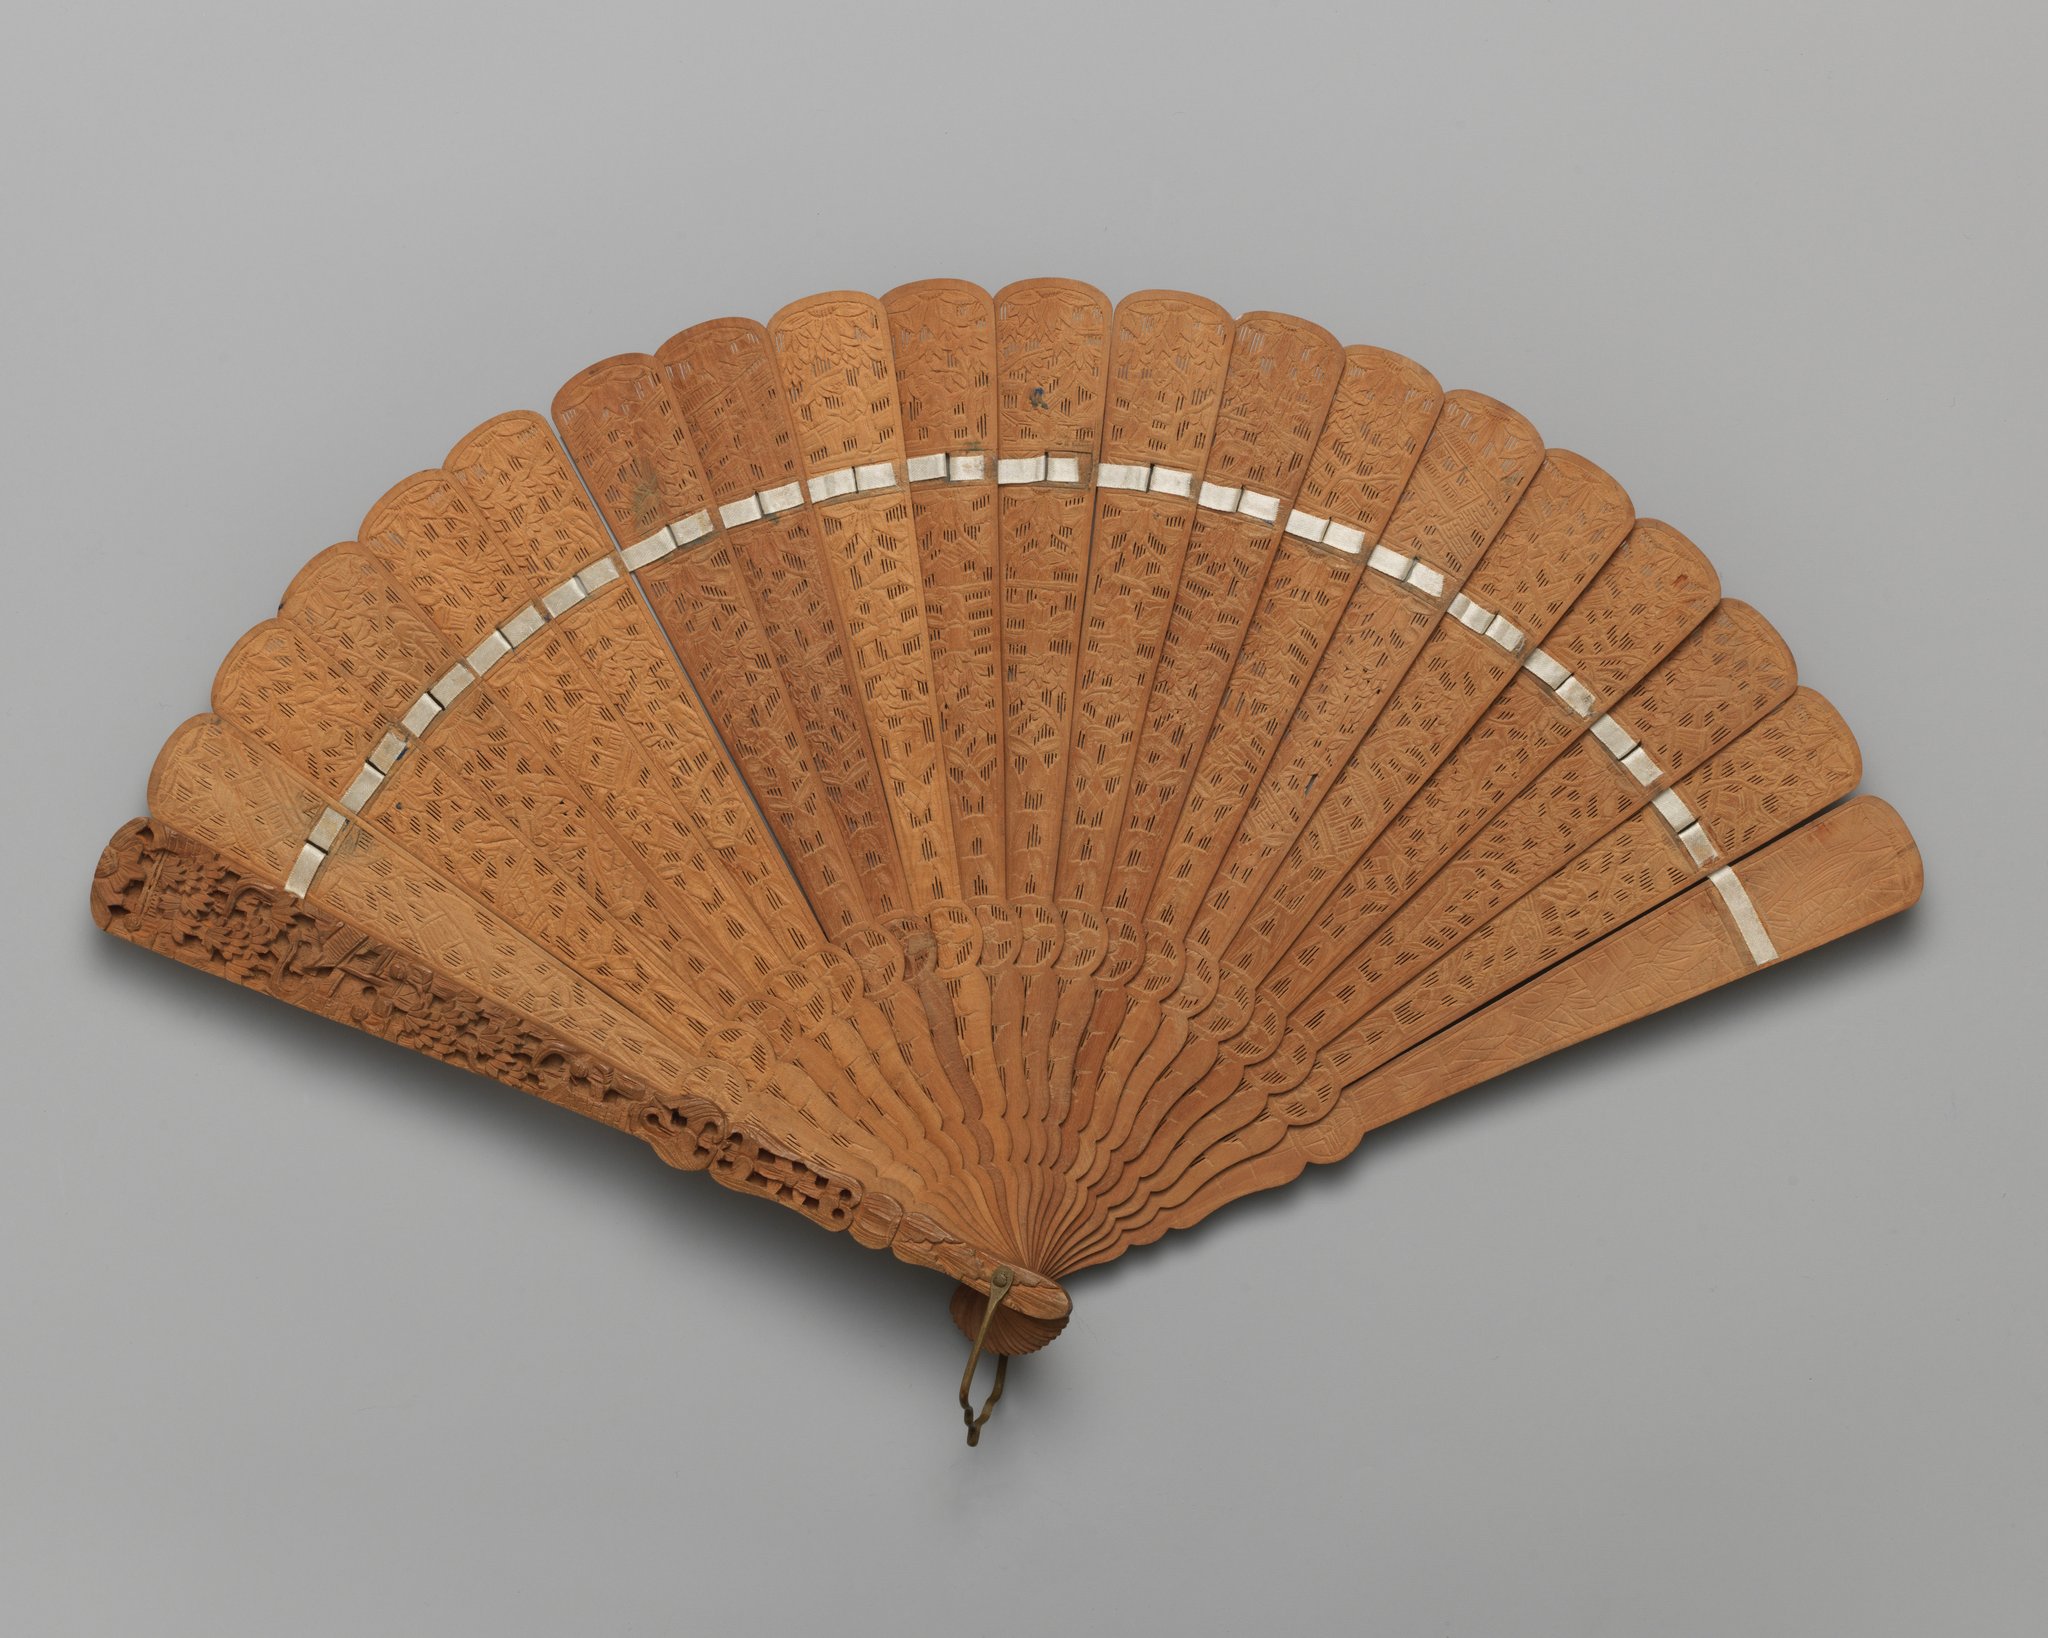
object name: fan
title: Brisé Fan, with Simple Carved Patterning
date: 1801-1900